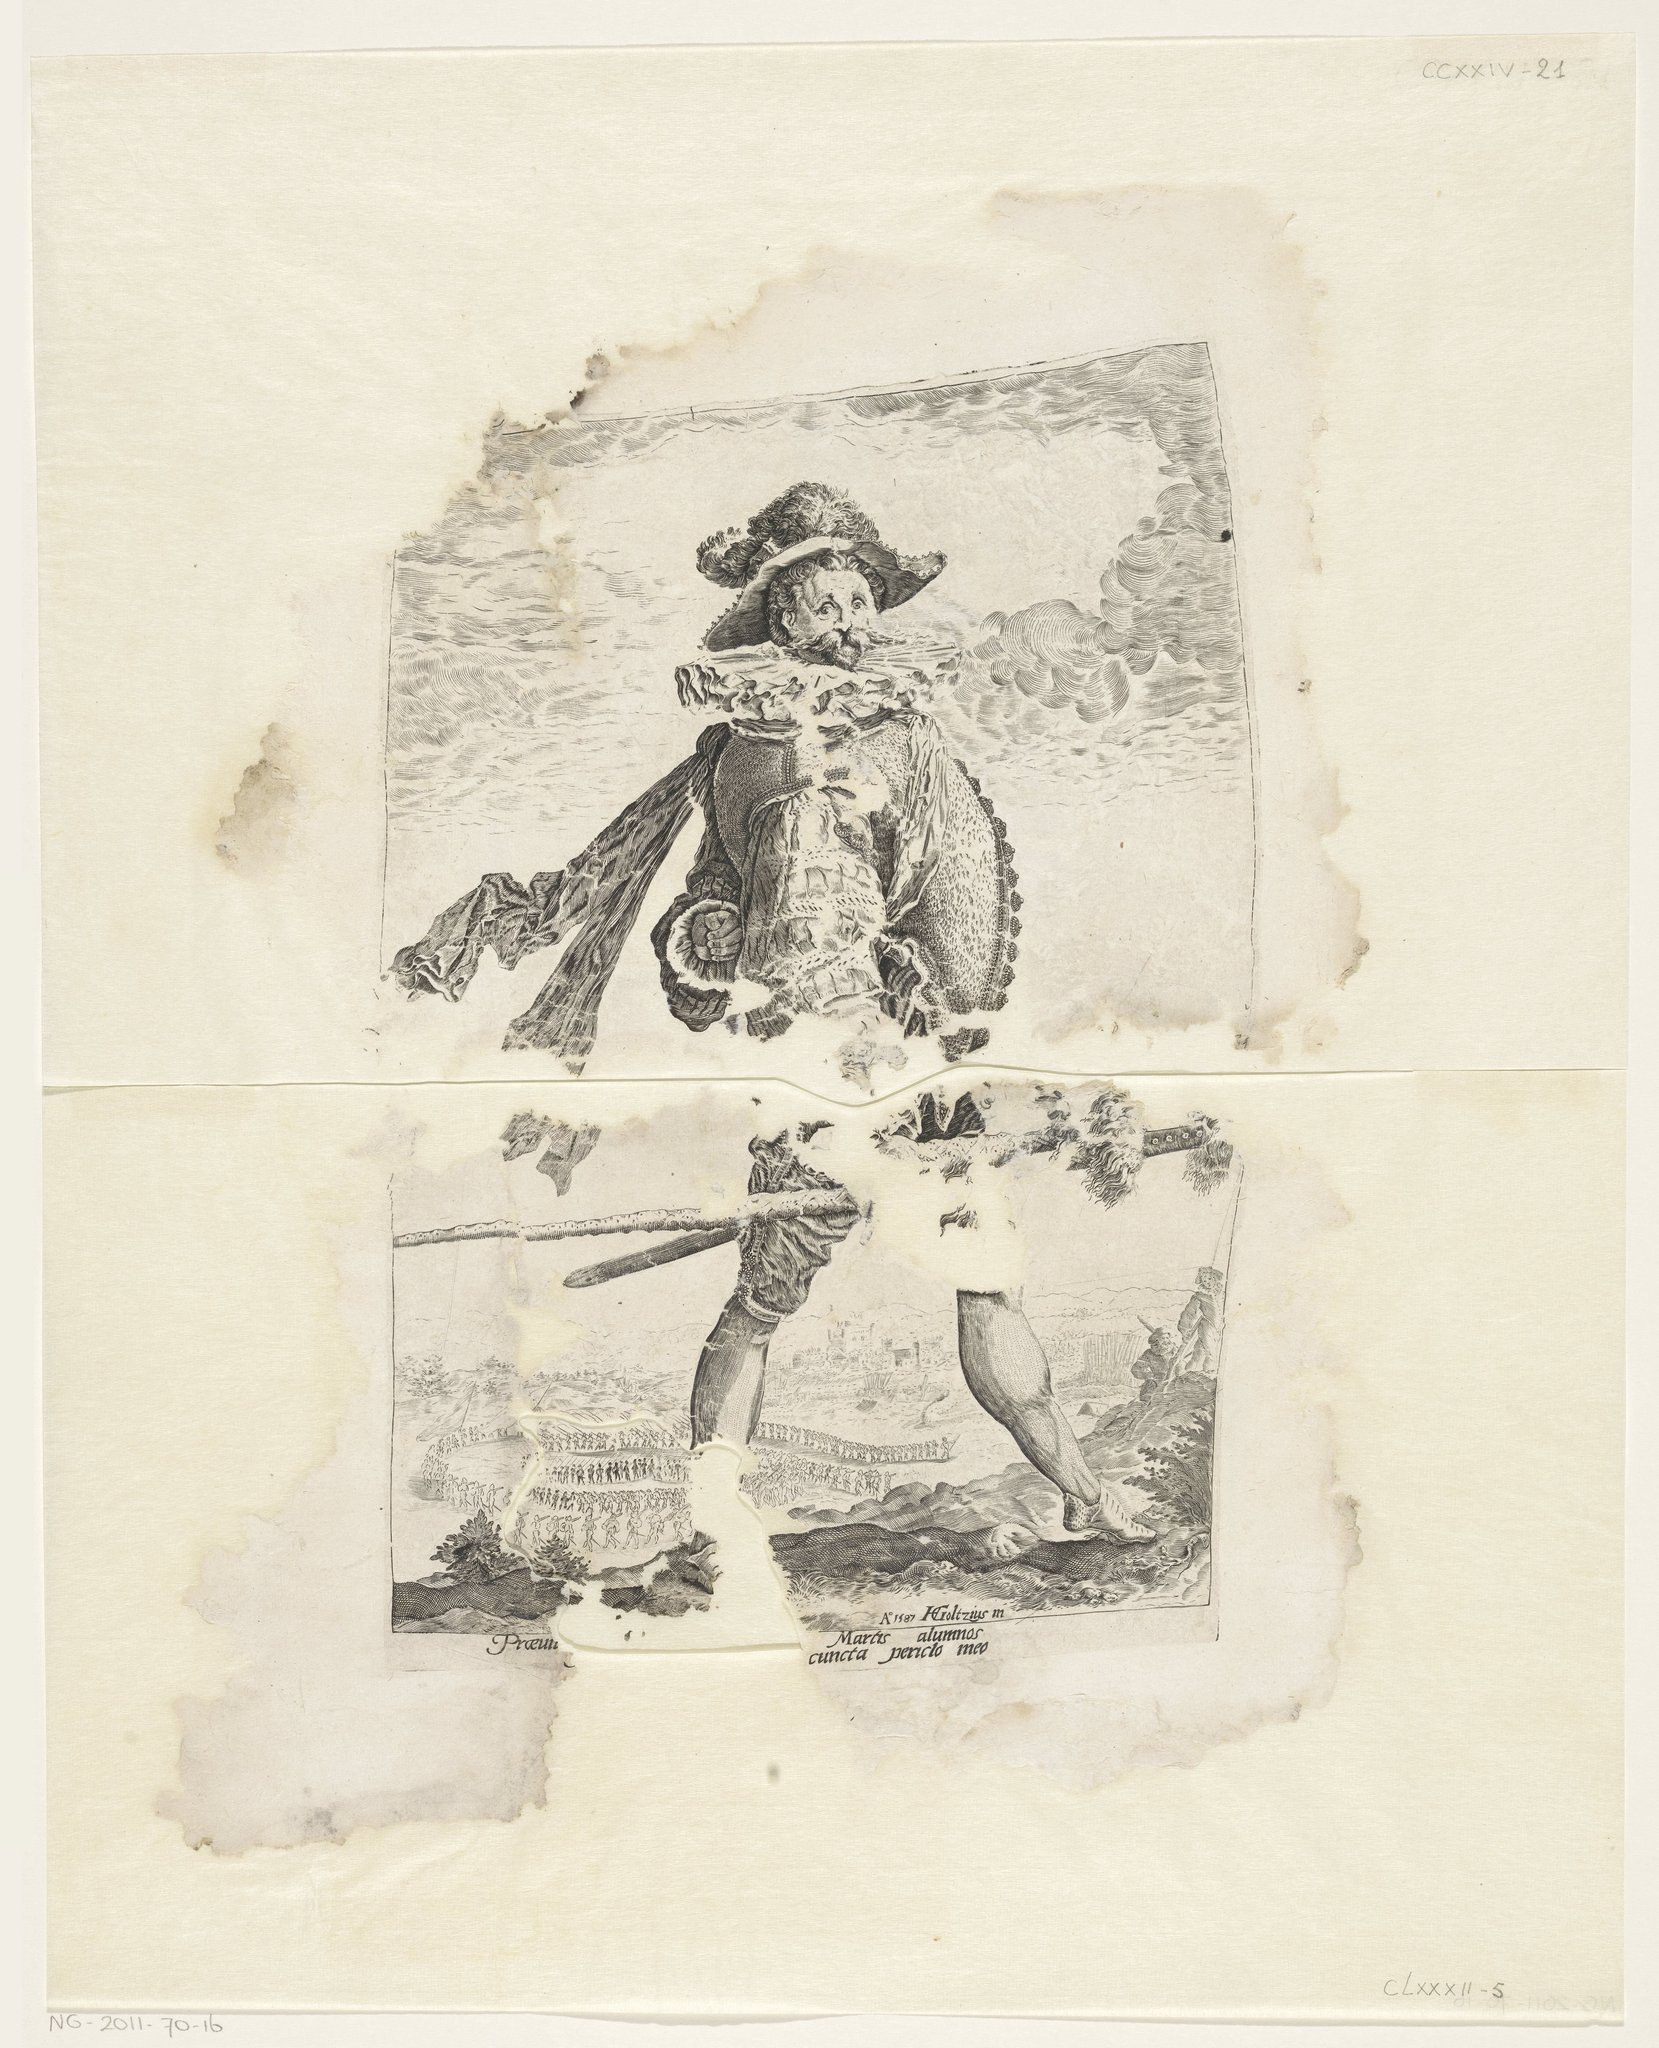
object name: print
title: Kapitein van de infanterie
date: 1587-1596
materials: paper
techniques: engraving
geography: northern netherlands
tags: officer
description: De prenten in de Nova Zembla collectie zijn tijdens een expeditie van Willem Barendsz en Jacob van Heemskerk in 1596-1597 noodgedwongen in het winterkamp, het ‘Behouden Huis’, op het eiland achtergelaten. De prenten waren in één of meerdere stapels als handelswaar meegenomen vanuit Amsterdam. Bijna drie eeuwen later, in 1871, keerde de Noor Elling Carlsen terug naar Nova Zembla en vond daar de restanten van het ‘Behouden Huis, inclusief een groot deel van de inventaris. Een deel van de prenten, in de vorm van aaneengekoekte kluiten, werd toen ook teruggevonden. De papierkluiten waren soms op meerdere plekken gebroken. Tussen 1975-1979 zijn de prenten van elkaar gescheiden. Dit leverde in totaal ca. 1000 fragmenten van ca. 400 afdrukken van ca. 150 verschillende prenten op. Voor zover mogelijk zijn de fragmenten samengevoegd en zijn de prenten gereconstrueerd.